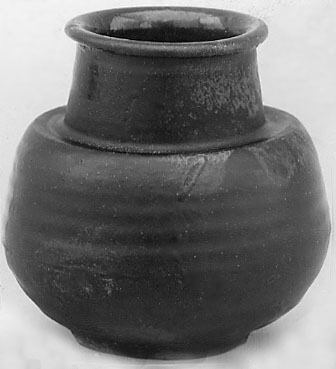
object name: tea jar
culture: japanese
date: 1701-1800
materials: clay, glaze